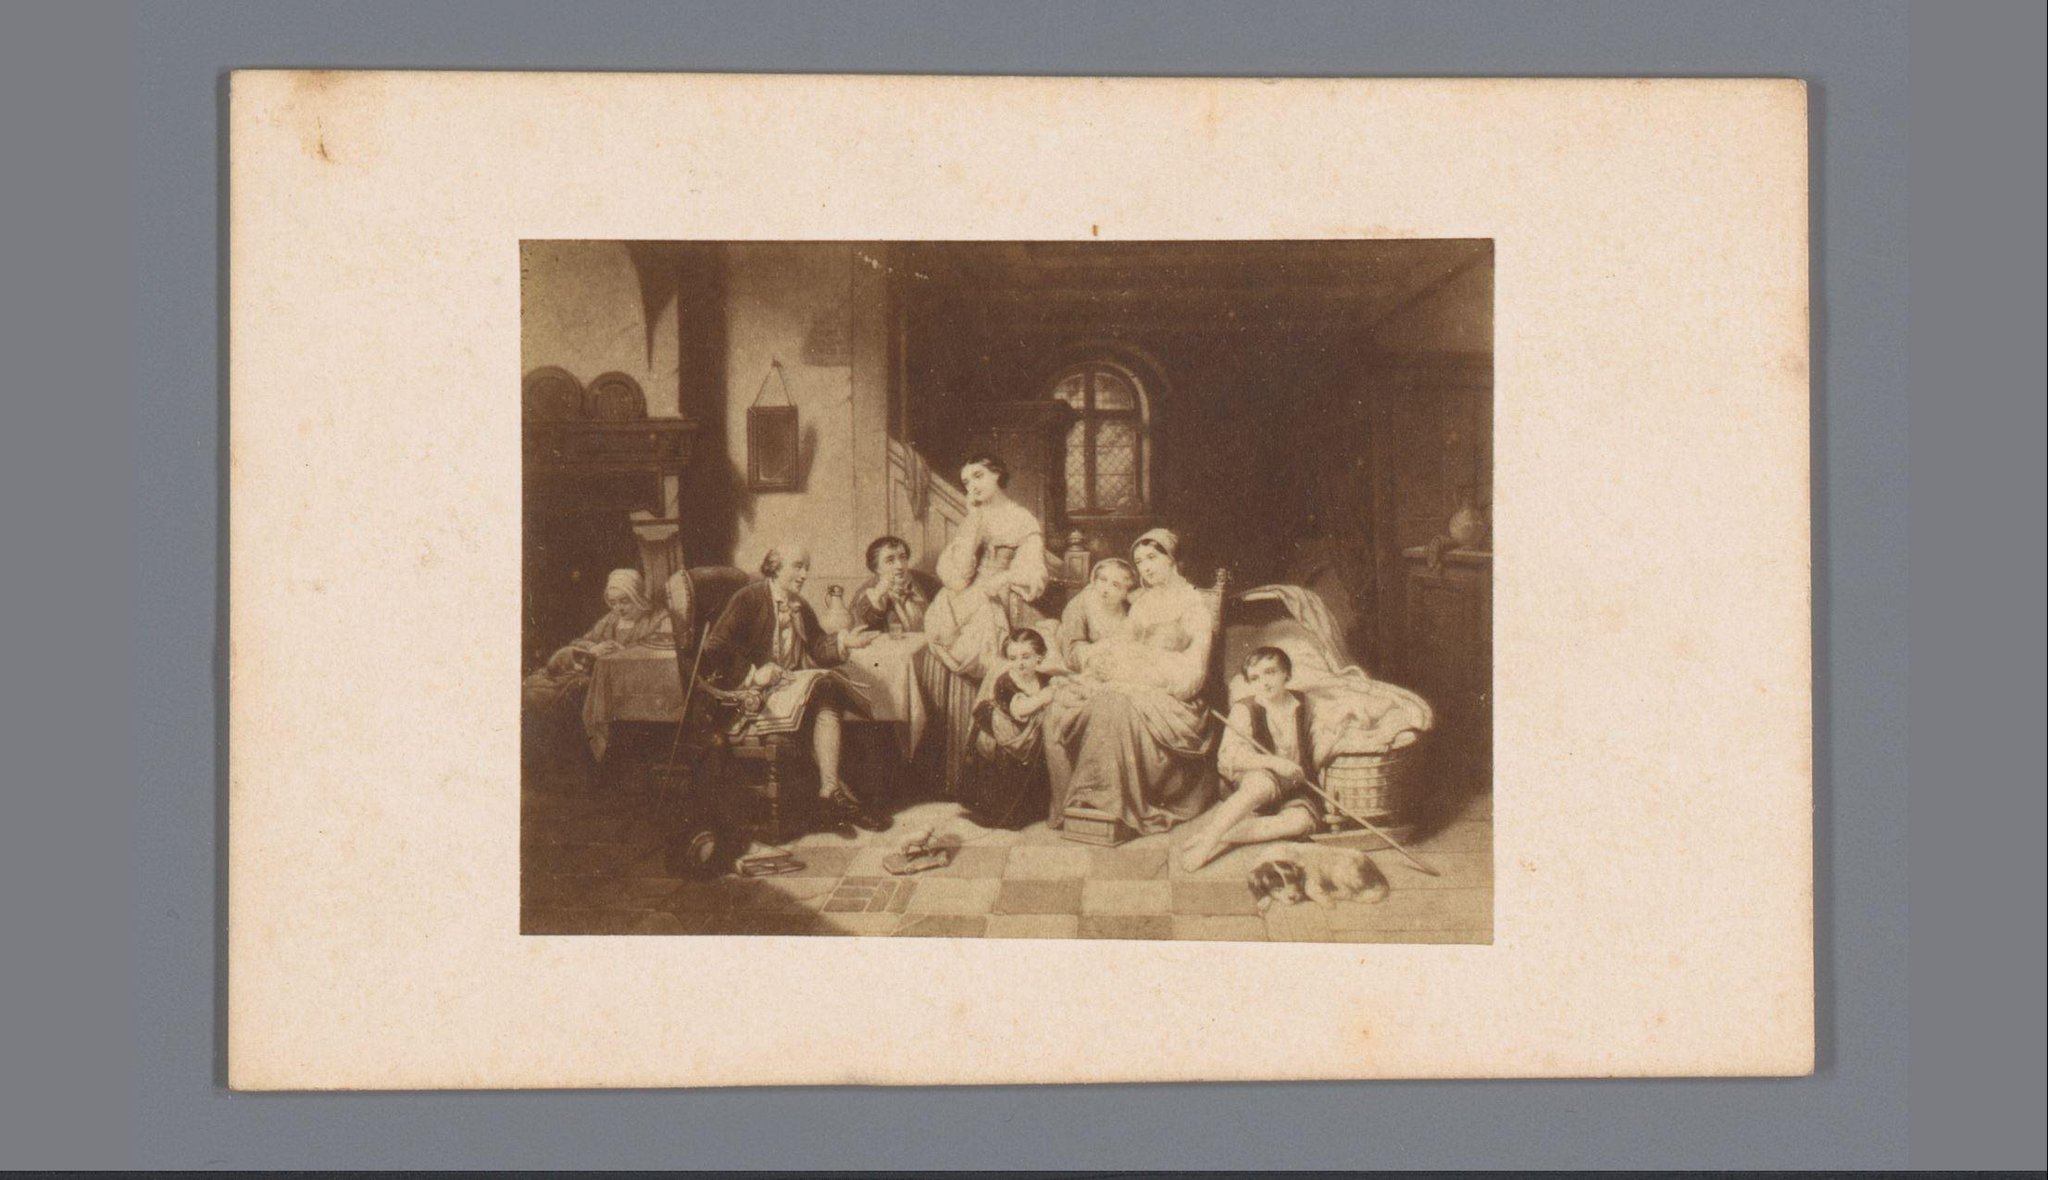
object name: photograph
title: Fotoreproductie van een ontwerp van een familietafereel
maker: Anonymous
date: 1855-1885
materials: cardboard, paper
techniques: albumen print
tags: family life at home